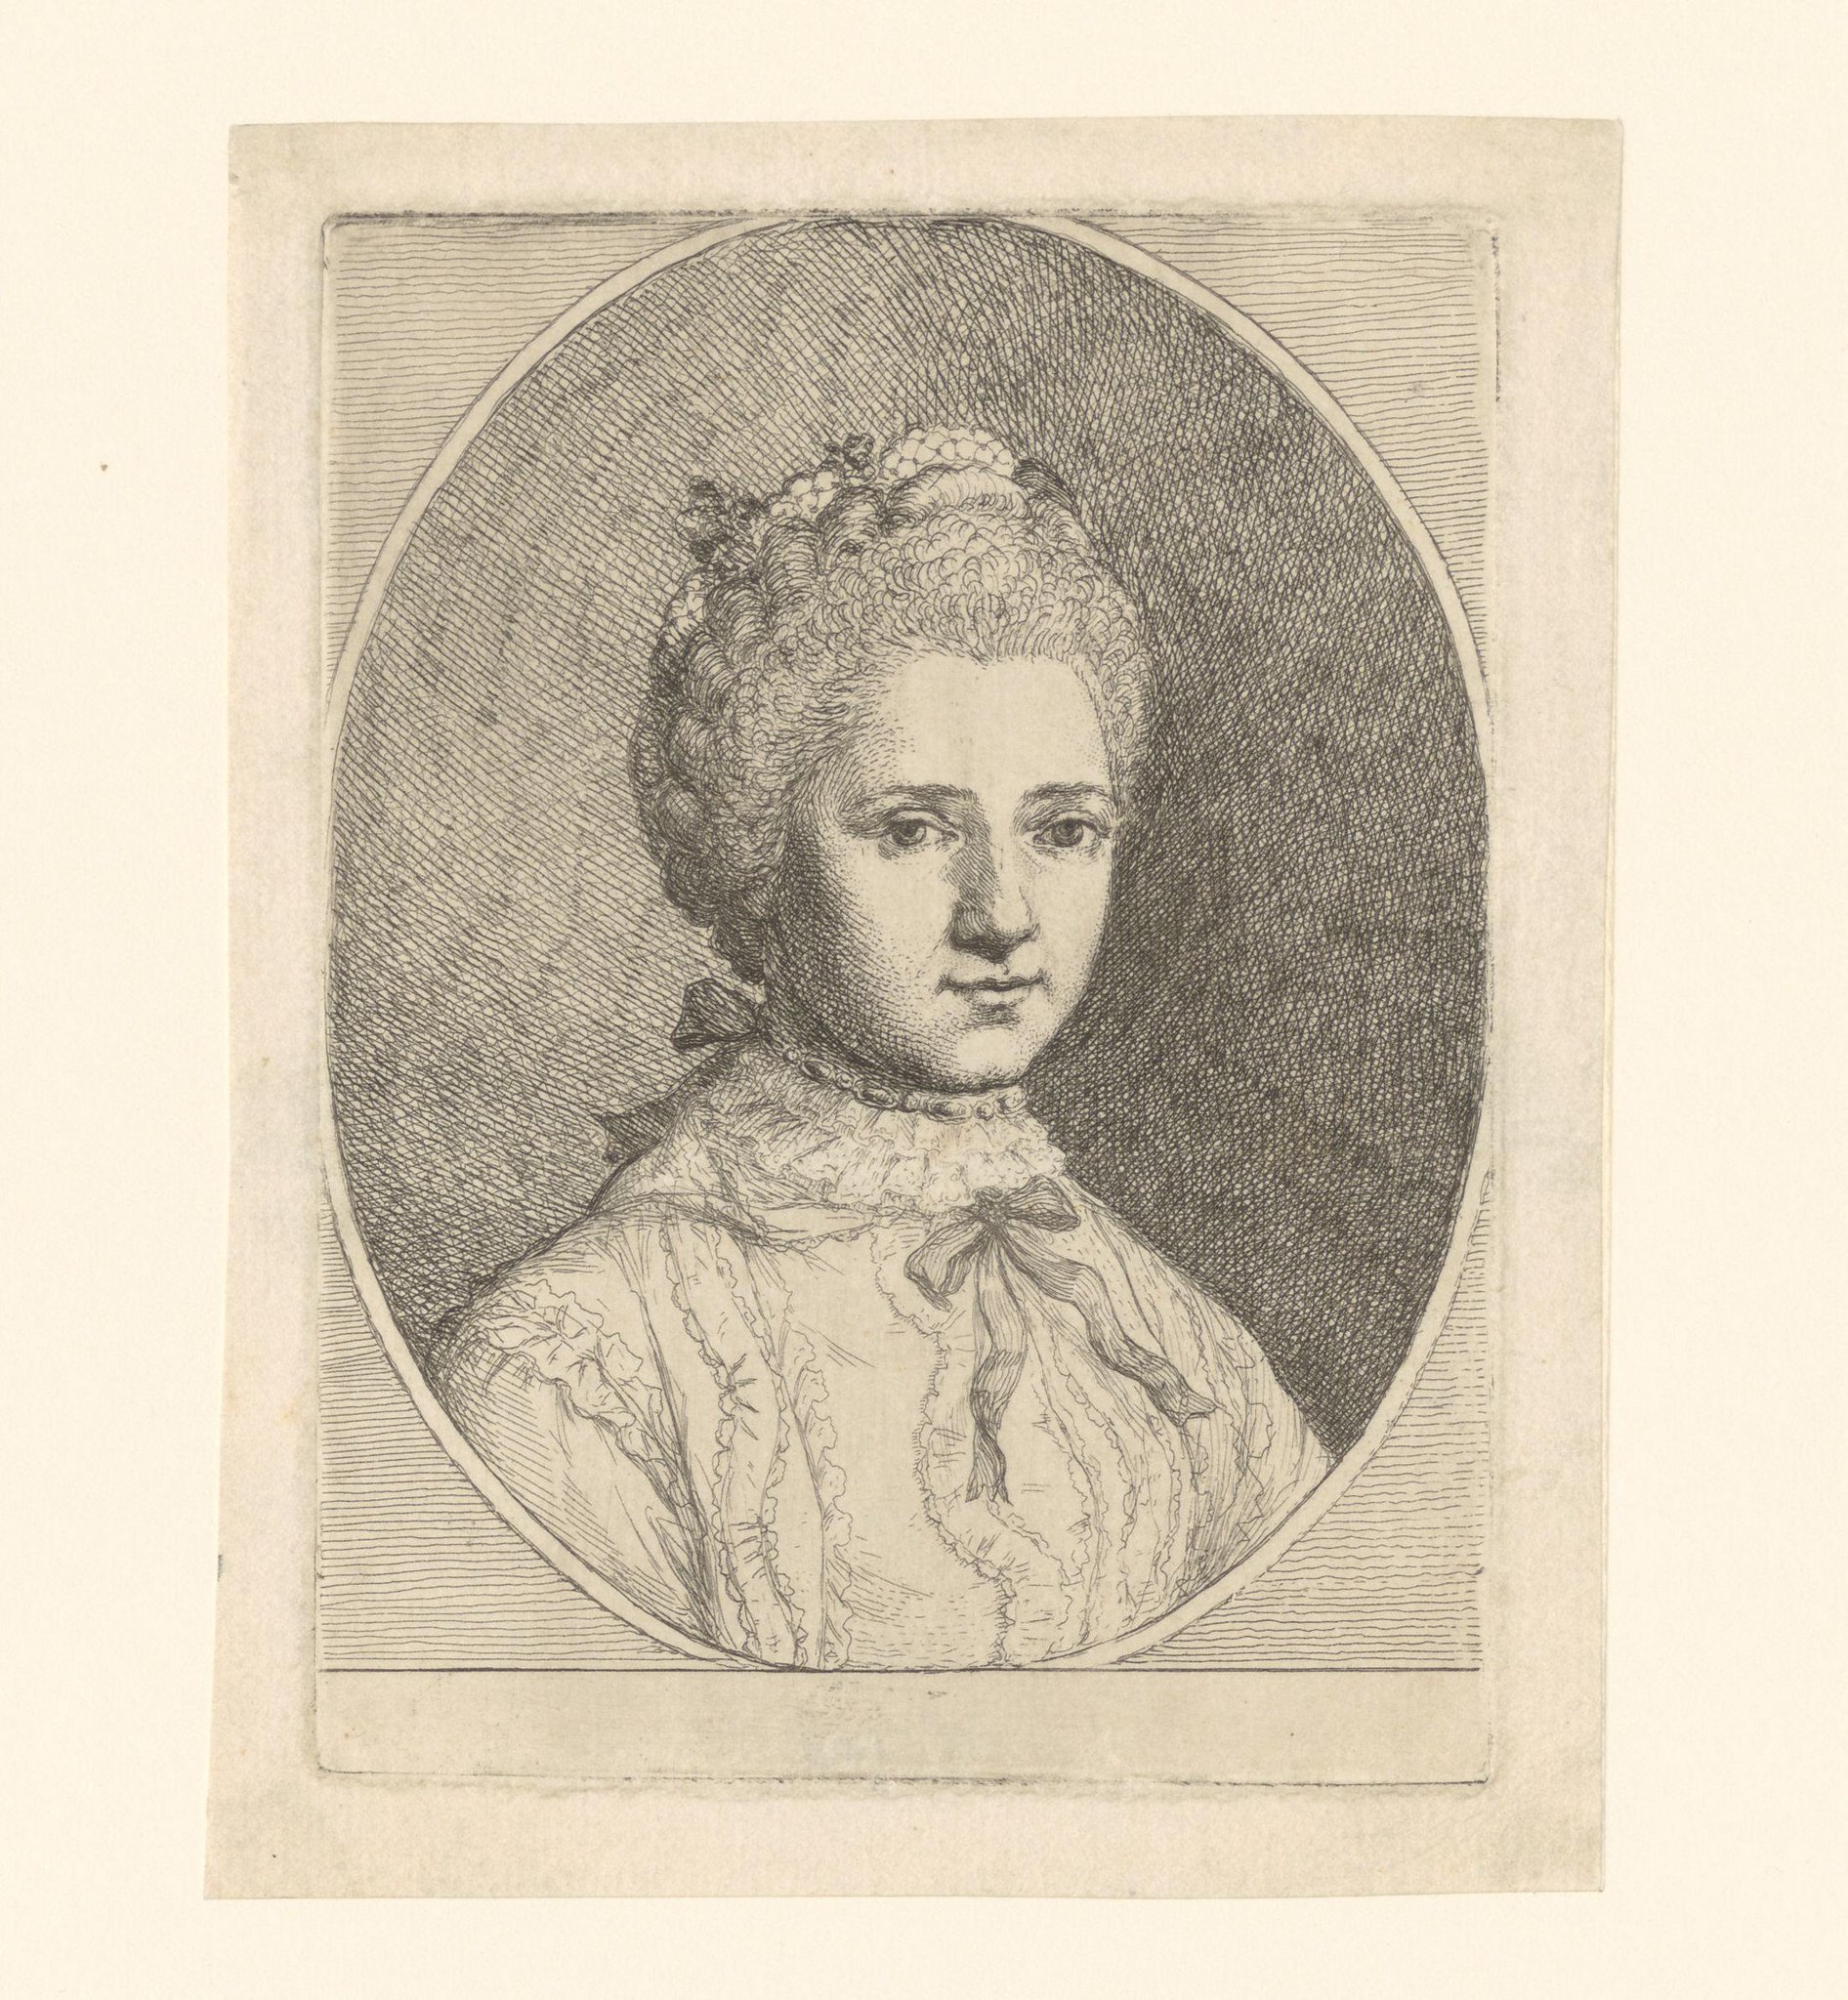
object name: print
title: Zelfportret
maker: angelica kauffmann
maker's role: draughtsman, print maker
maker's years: 1741-1807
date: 1751-1807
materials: paper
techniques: etching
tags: angelica kauffmann, historical persons, portrait, self-portrait of painter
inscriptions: collector's mark: Lugt 2228